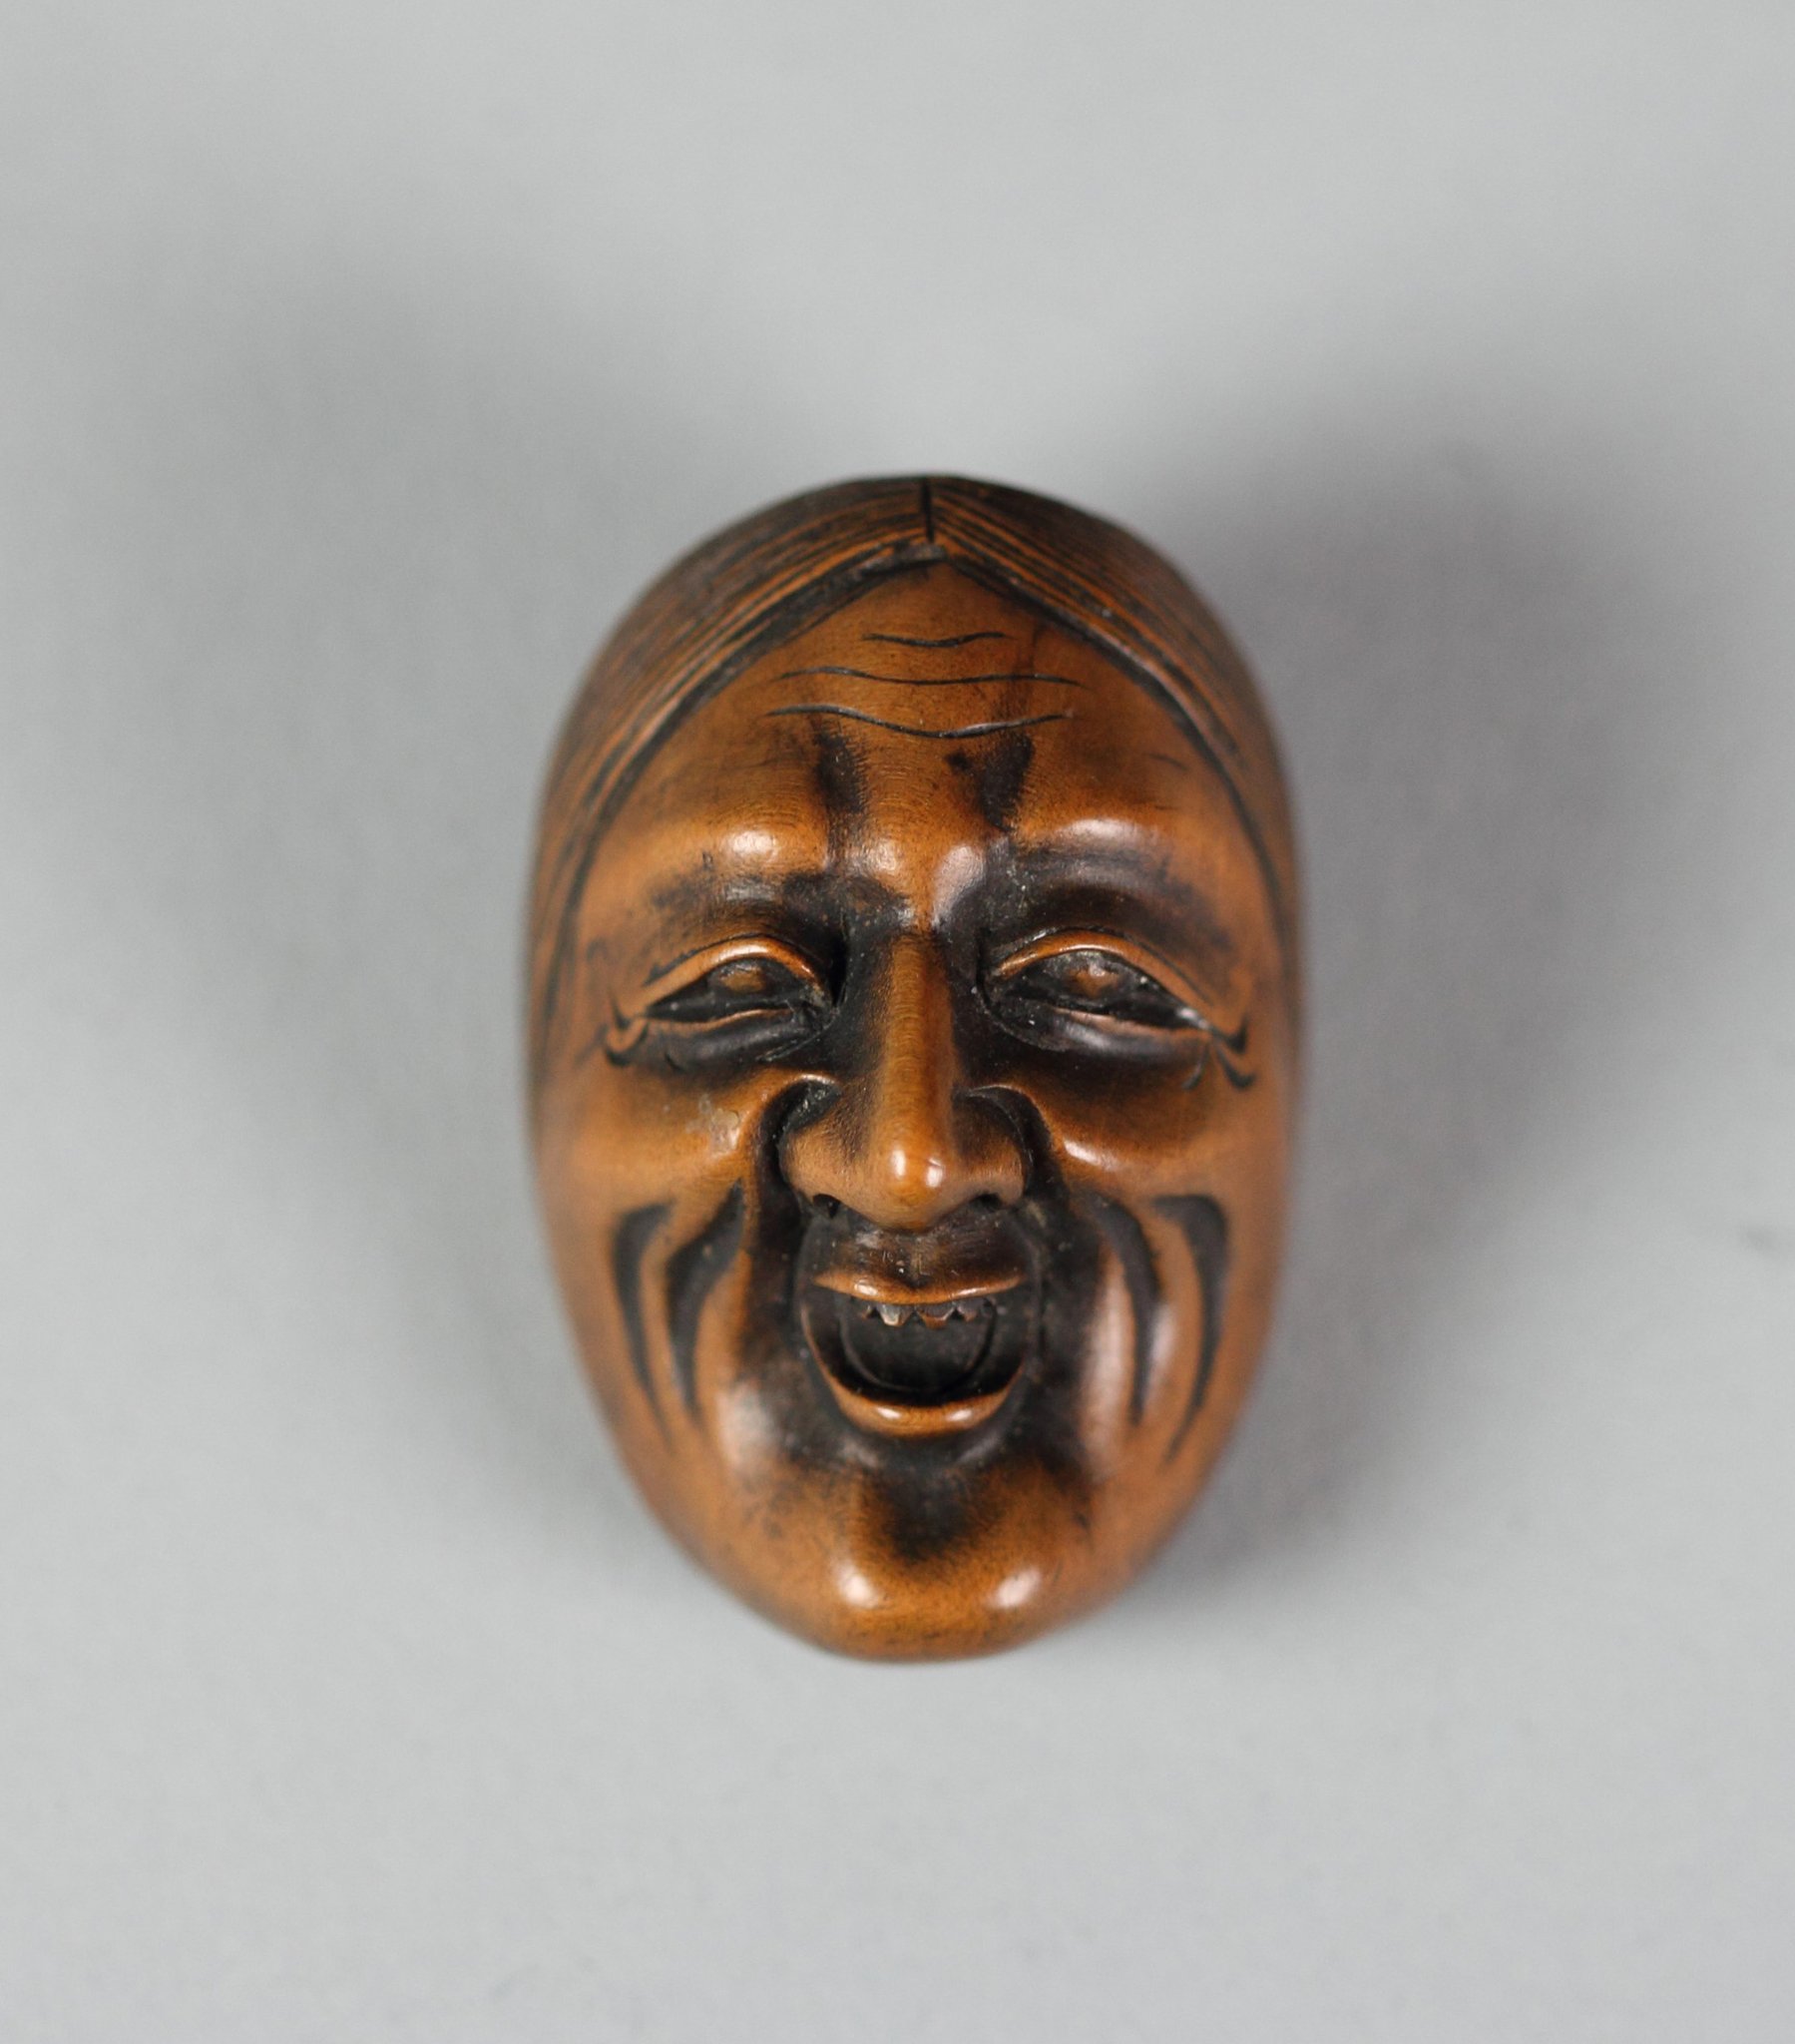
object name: netsuke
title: Netsuke of Noh Mask; Uba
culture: japanese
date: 1701-1800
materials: wood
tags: masks